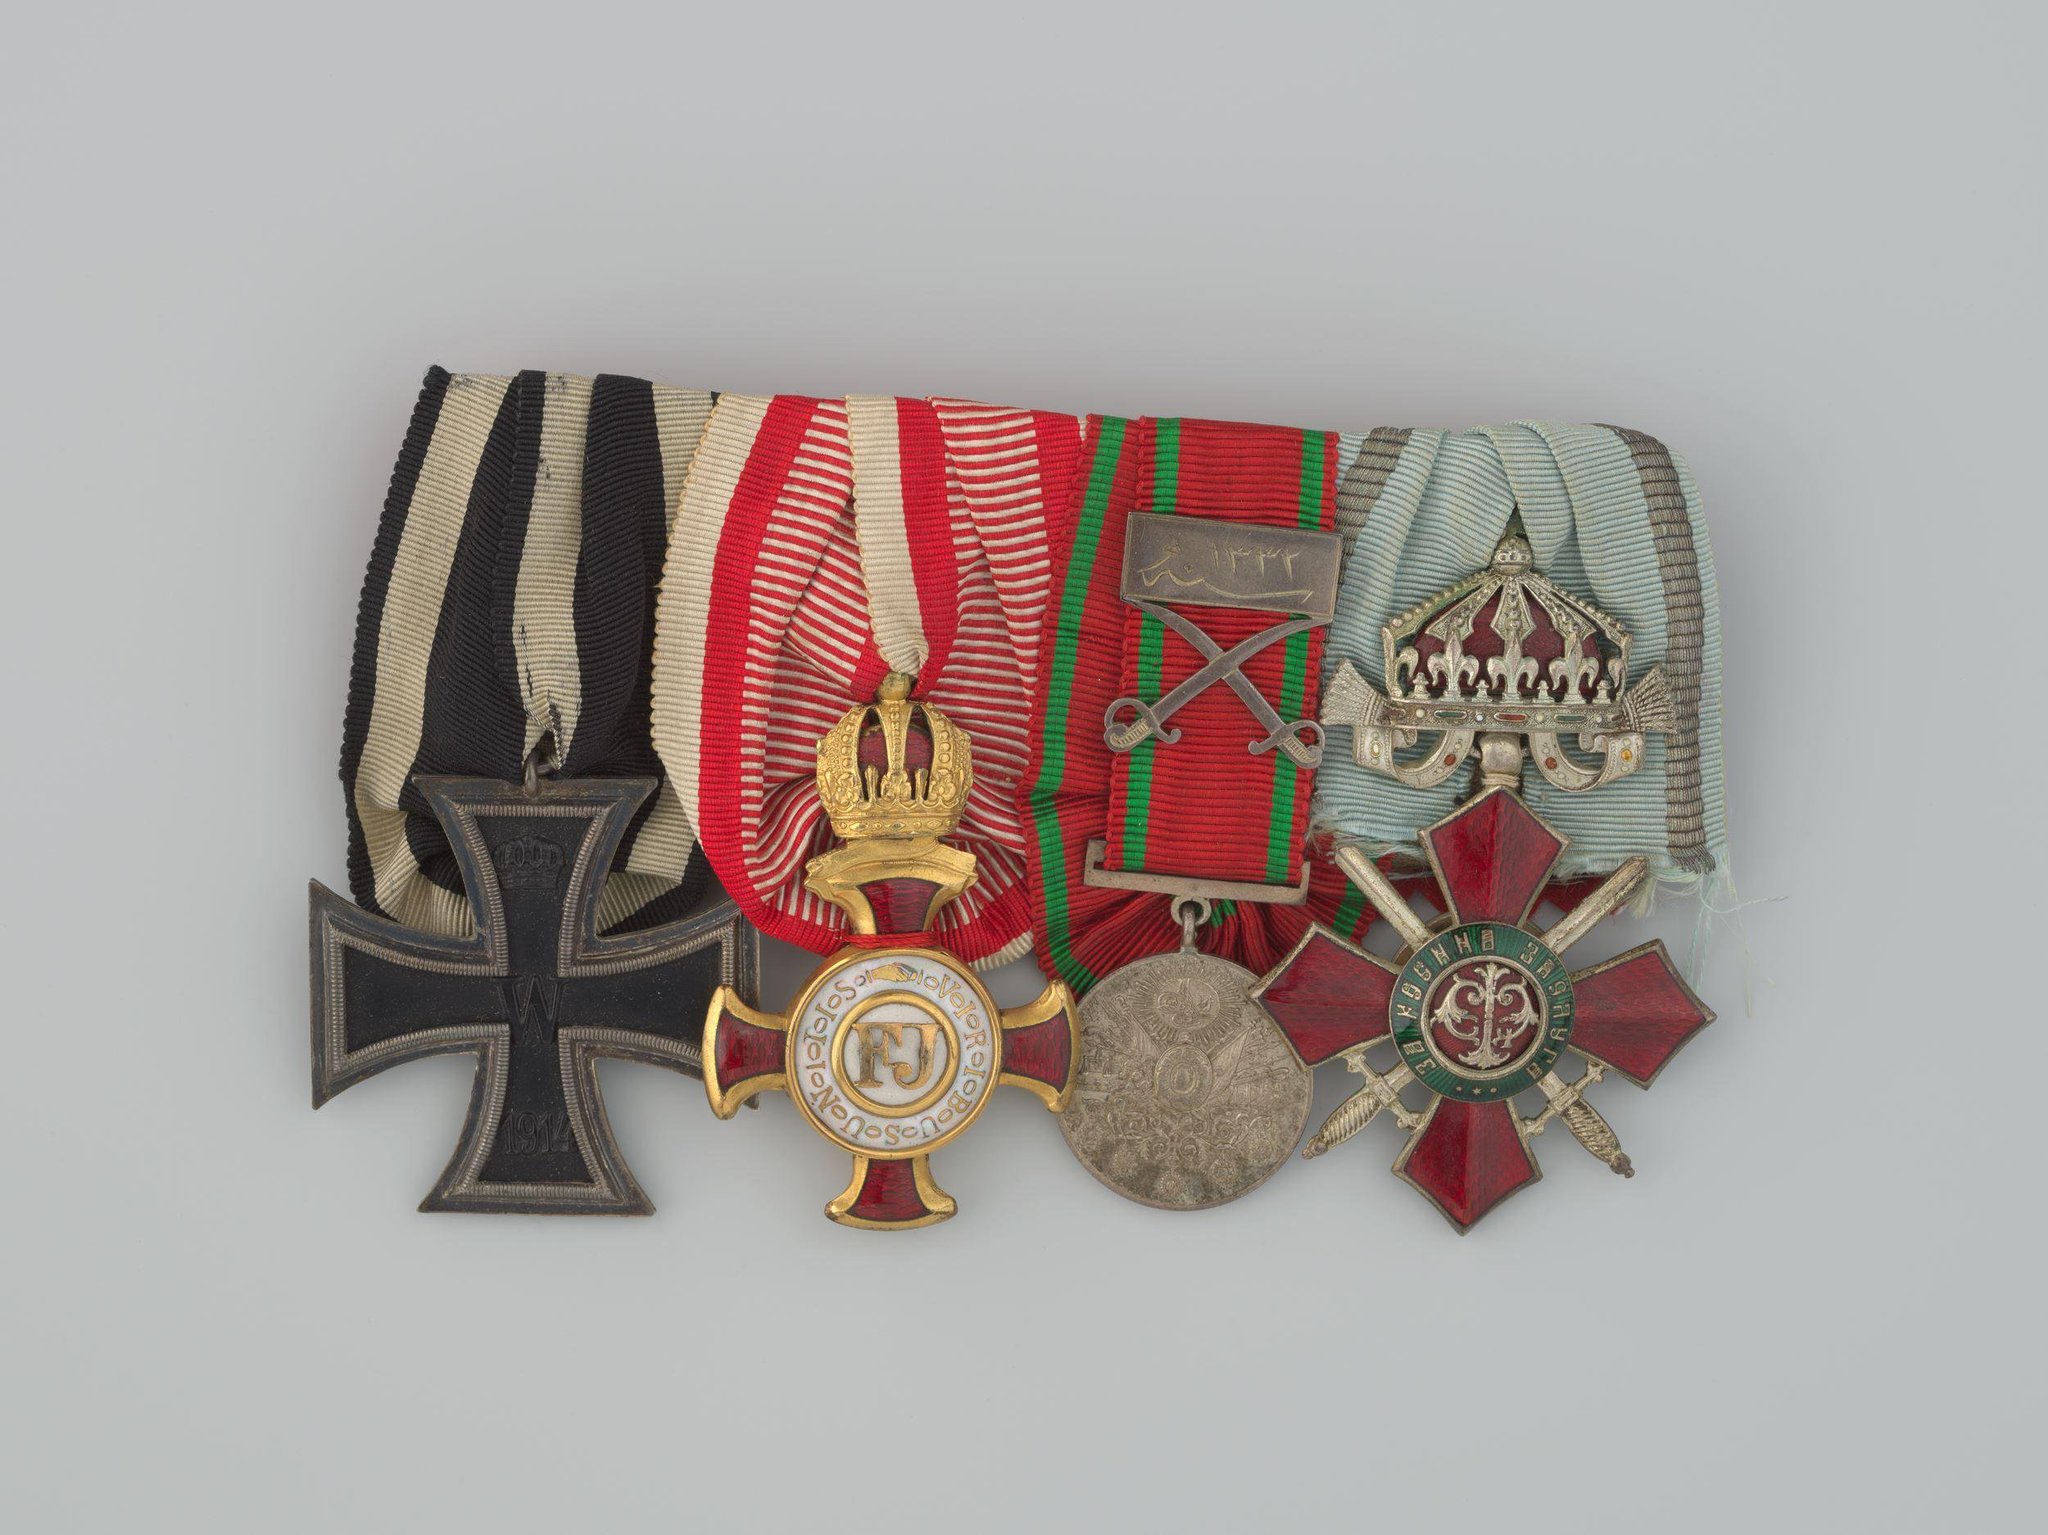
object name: onderscheidingsteken, onderscheiding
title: IJzeren Kruis (Duitsland) Tweede Klasse aan lint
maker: Anonymous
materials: iron, silk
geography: germany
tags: eugen wachenheimer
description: Dit object is onderdeel van de nalatenschap van Isabel Elon-Wachenheimer (1928-2010). Tot haar overlijden behoorde het samen met de andere objecten uit de nalatenschap tot haar privédomein van Isabel Wachenheimer. In die particuliere context zijn deze objecten tezamen en individueel aandenkens - aan de jeugd, ouders en familie van Isabel Wachenheimer vóór en tijdens de Shoah en aan haar leven na de Tweede Wereldoorlog. Isabel Wachenheimer, die van juni 1943 tot mei 1945 gevangen zat in Kamp Westerbork, Theresienstadt, Auschwitz, Lenzing a/d Oberdonau (een buitenkamp van Mauthausen), overleefde de Shoah. Haar ouders – Eugène Wachenheimer en Else Wachenheimer-Moos - werden op 14 oktober 1944 in Auschwitz-Birkenau vermoord.